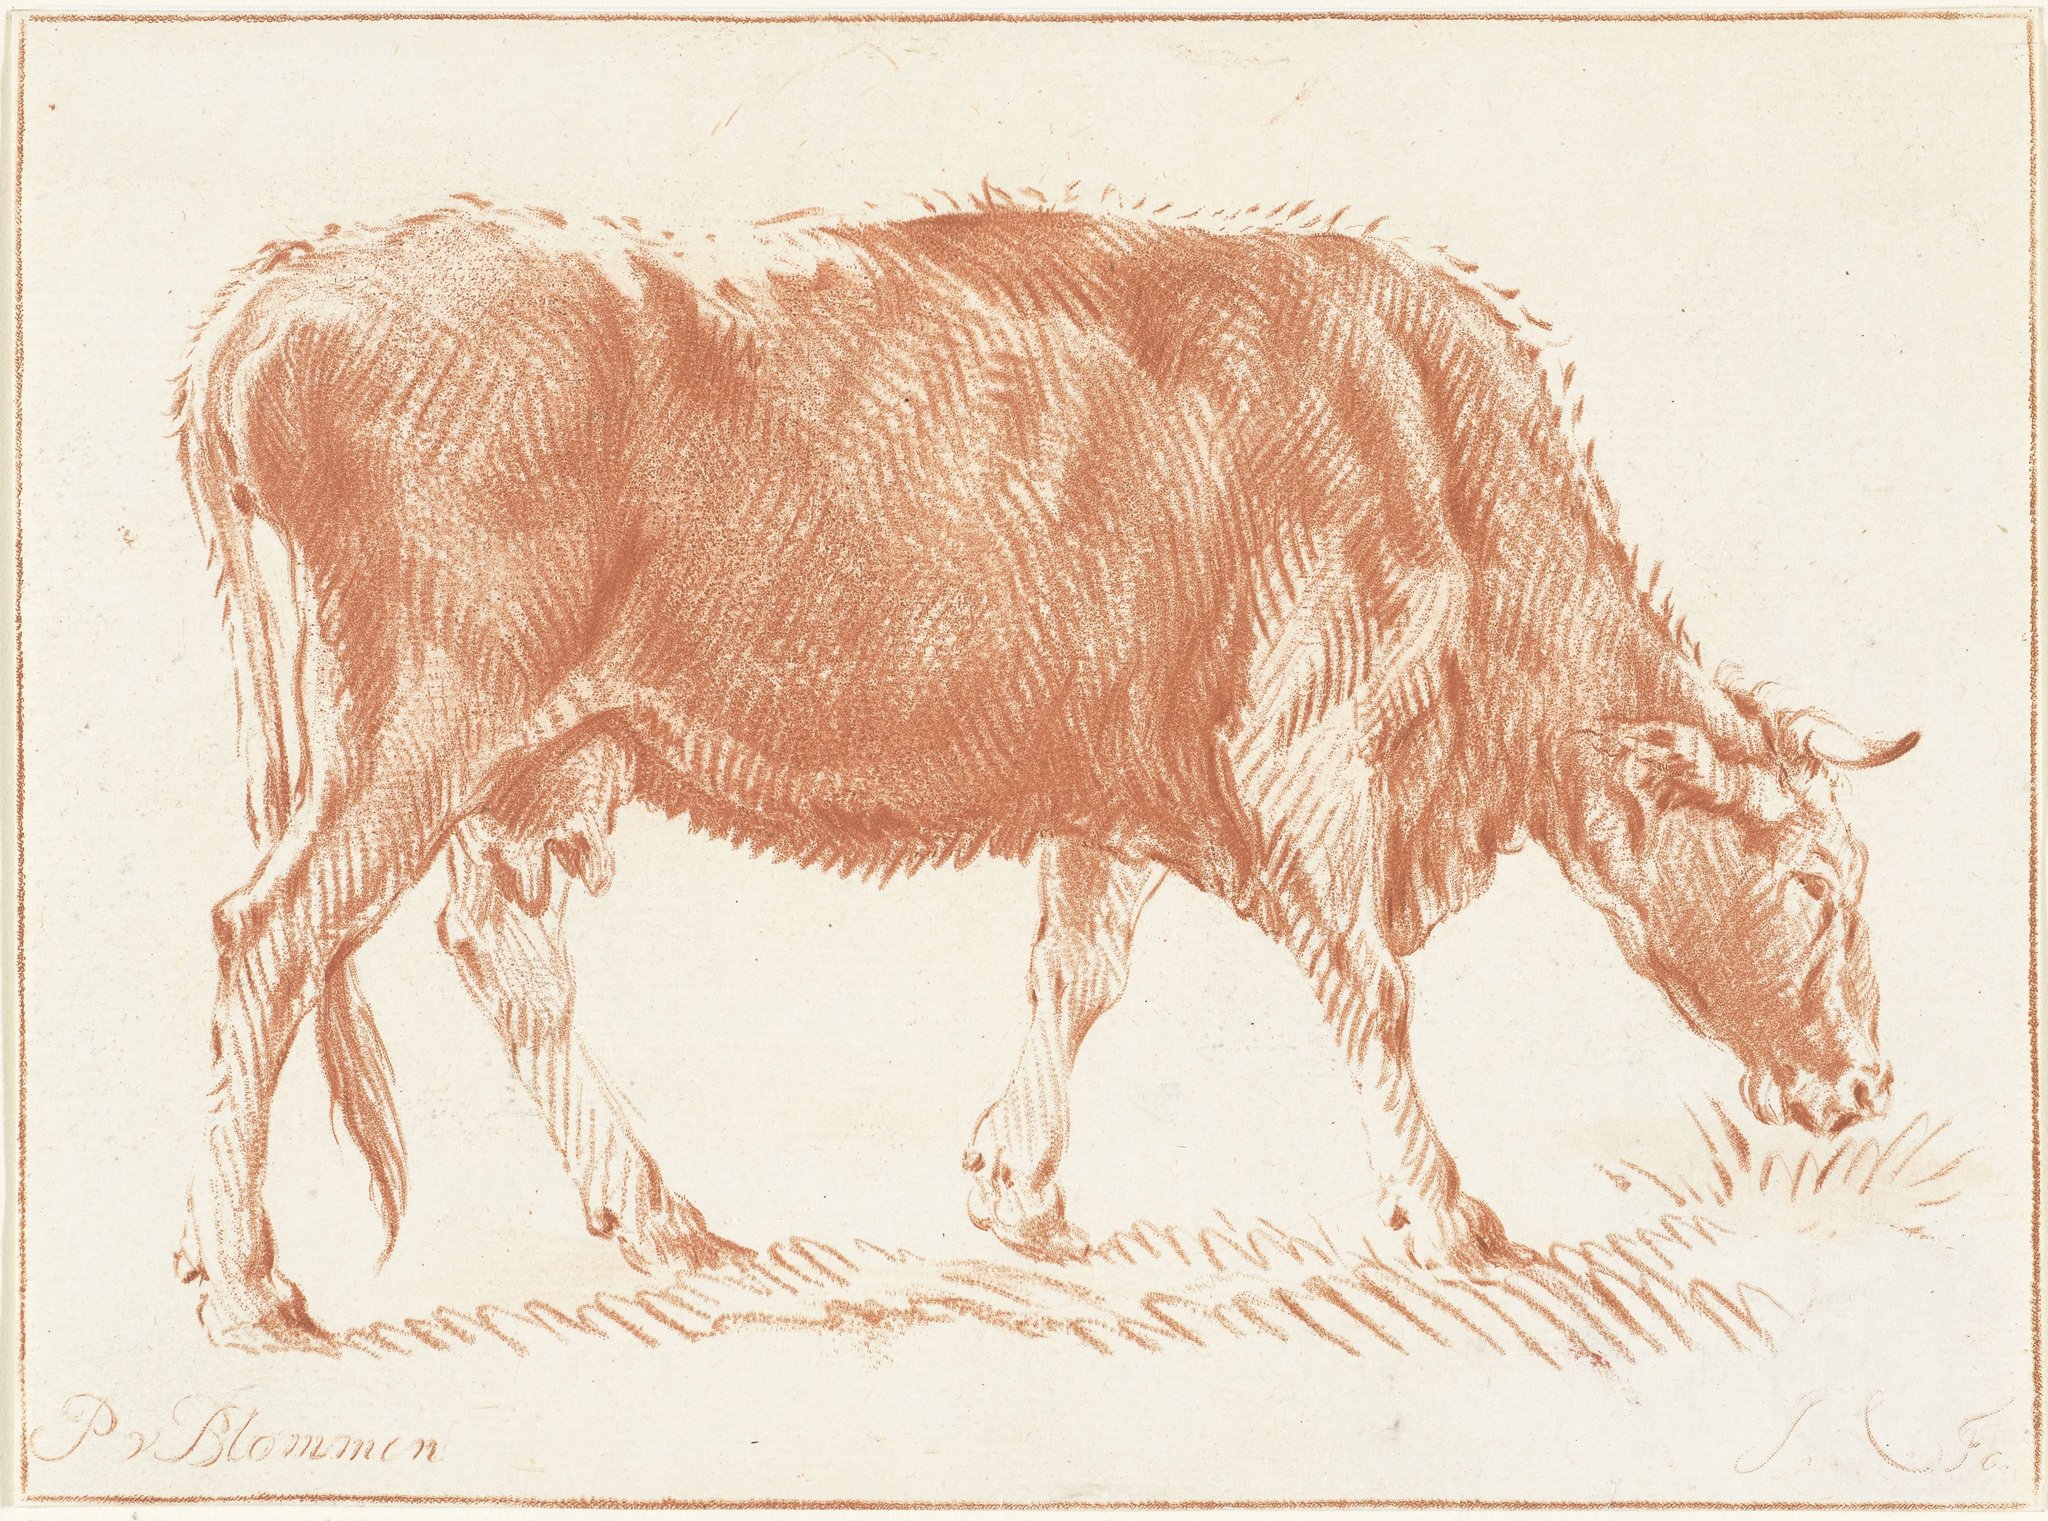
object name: print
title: Grazende koe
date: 1724-1798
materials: paper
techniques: printmaking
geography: antwerp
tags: cow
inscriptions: collector's mark: Lugt 2725, collector's mark: Lugt 2228